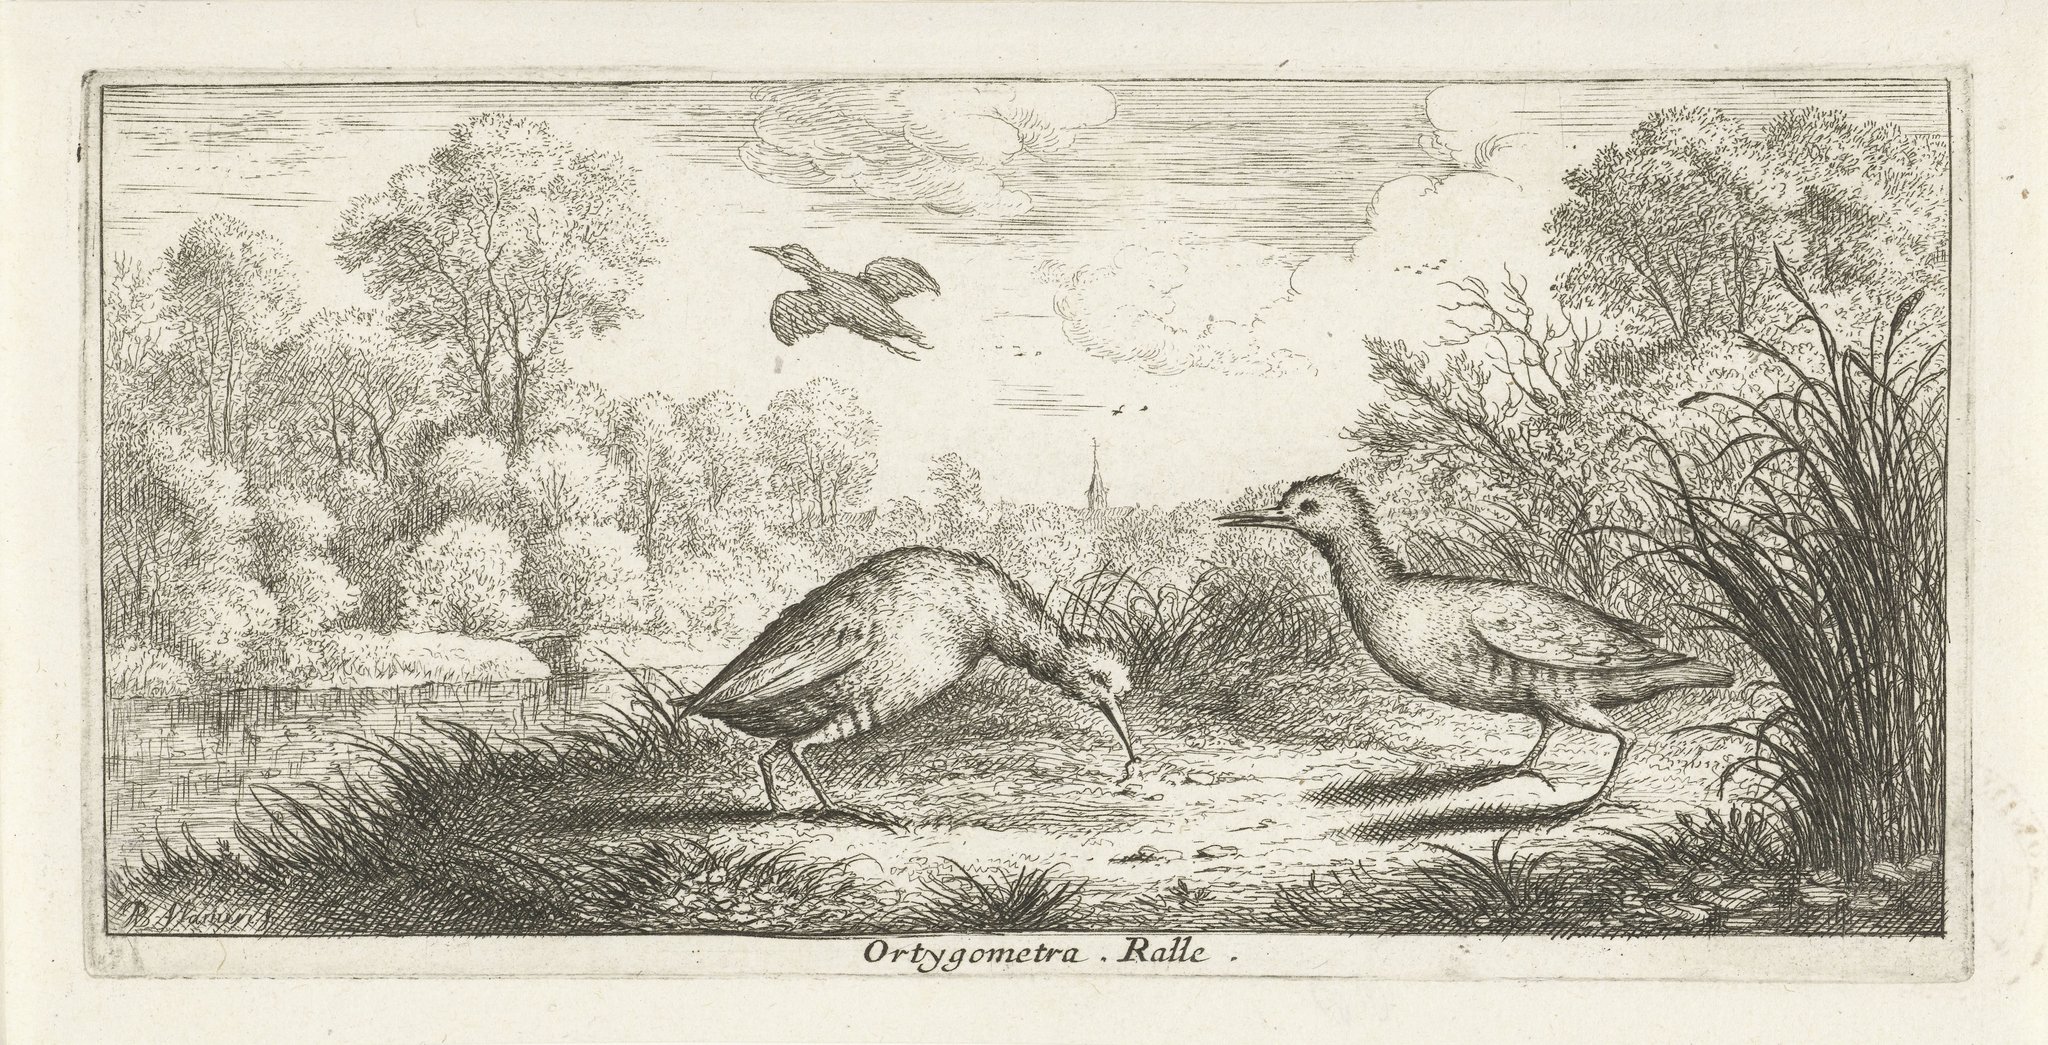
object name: print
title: Ortygometra. Ralle.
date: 1648-1692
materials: paper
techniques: etching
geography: france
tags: shore-birds and wading-birds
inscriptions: collector's mark: Lugt 240